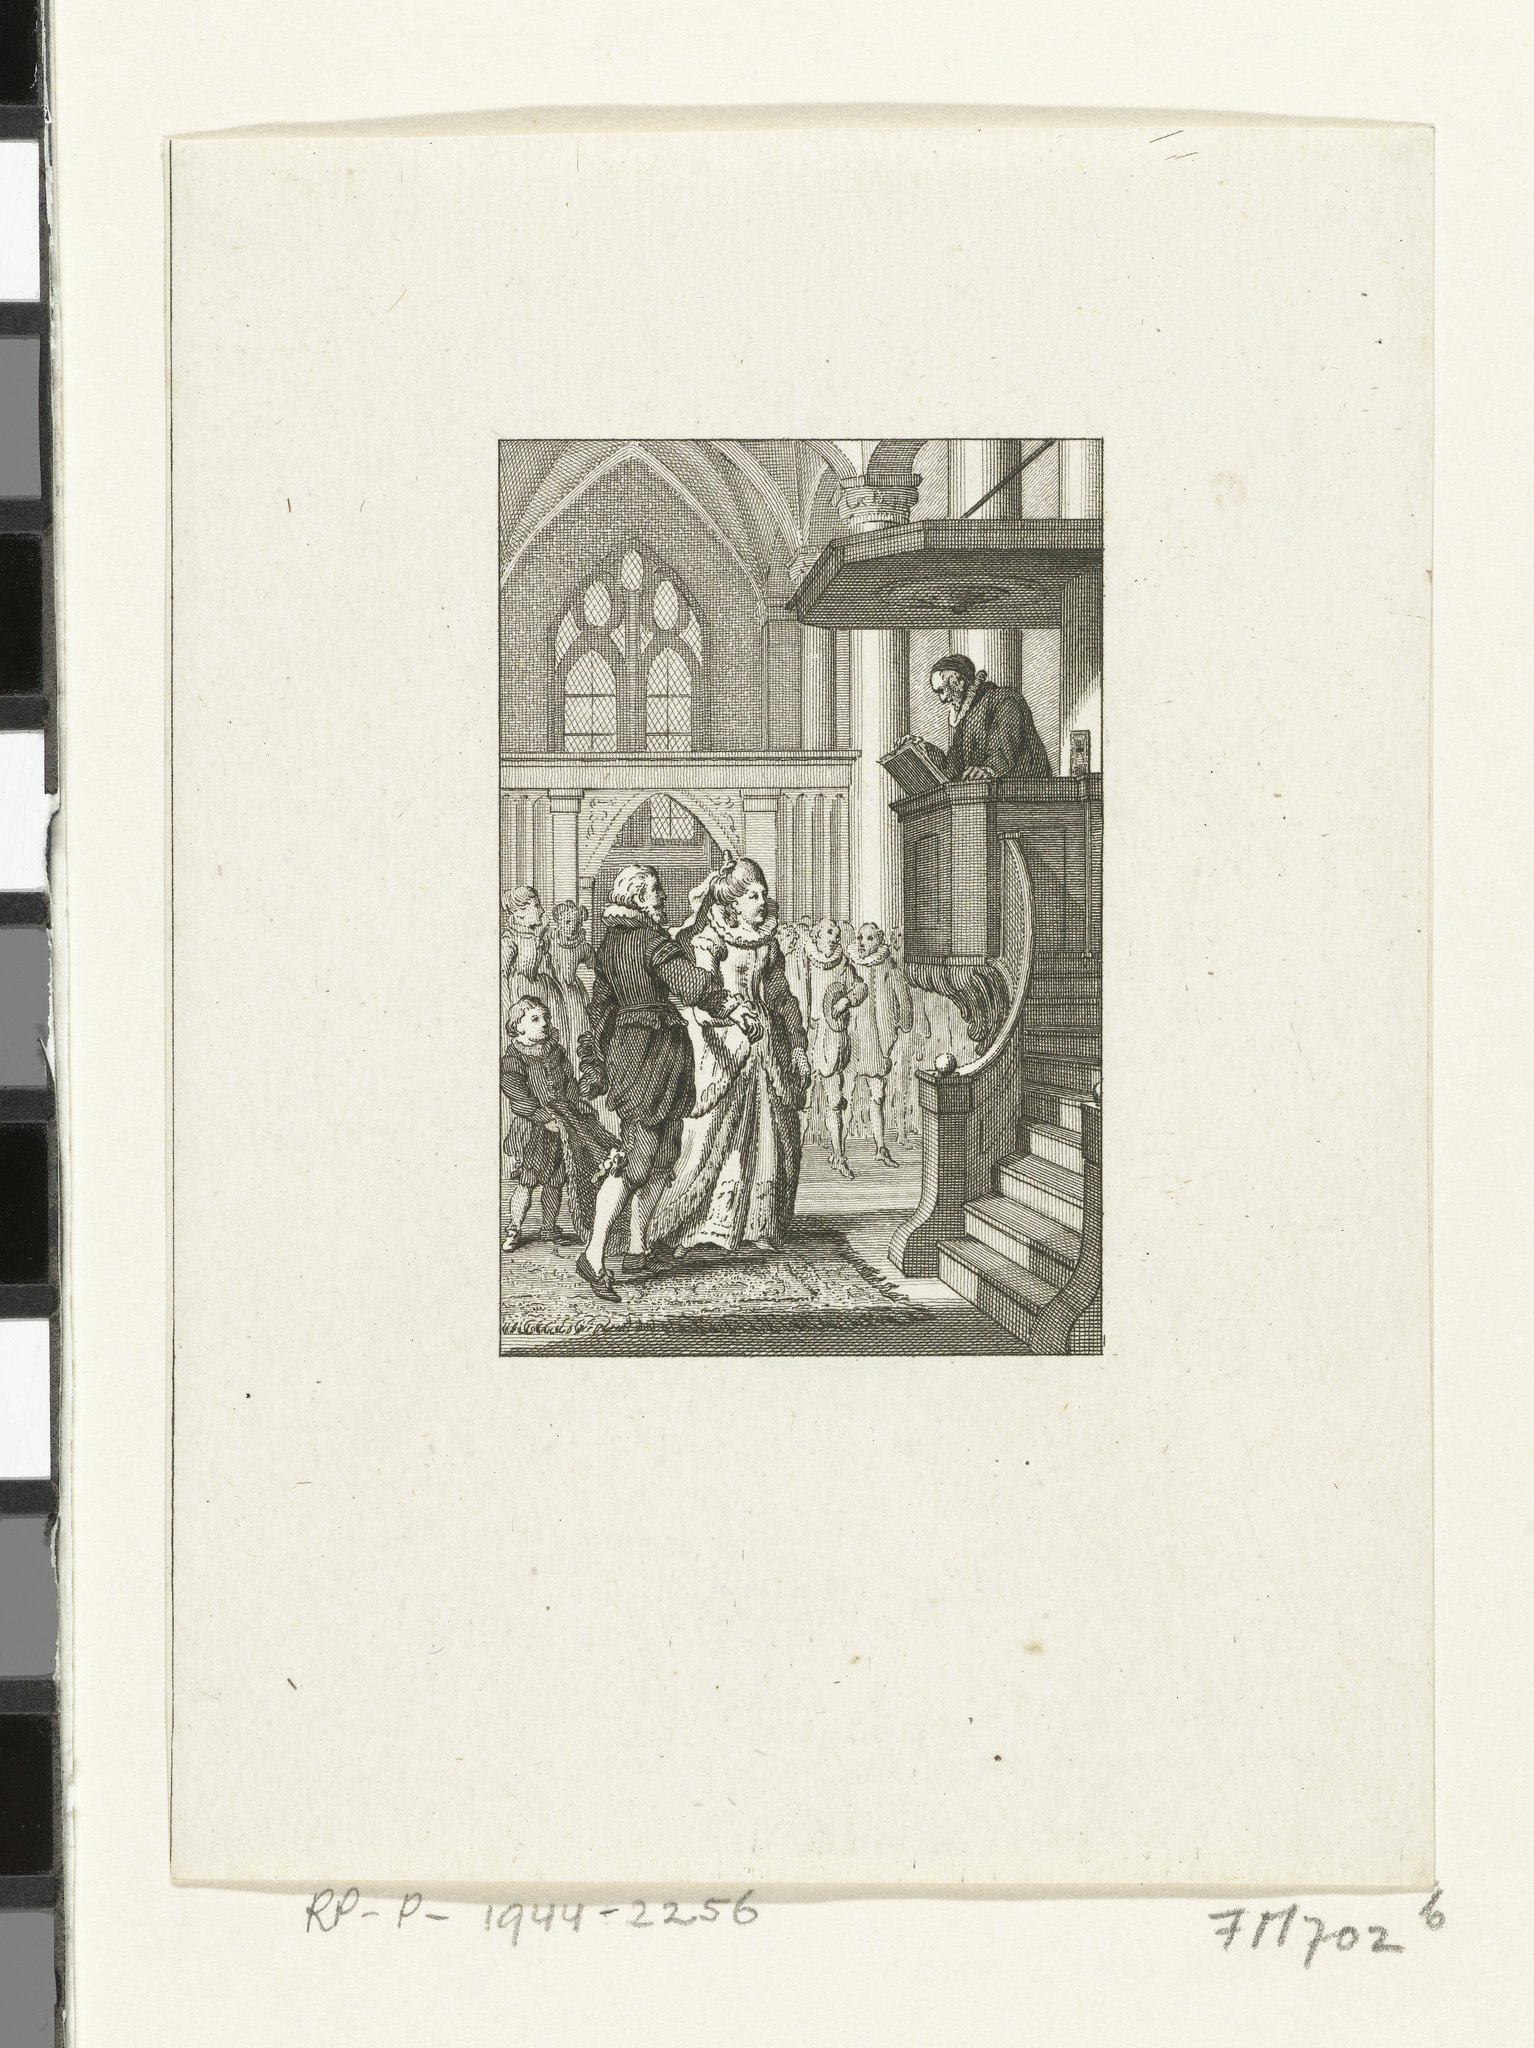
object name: history print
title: Huwelijk van Willem van Oranje en Charlotte de Bourbon, 1575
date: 1780-1795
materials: paper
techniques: etching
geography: netherlands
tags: antwerp, charlotte of bourbon, william i (prince of orange), (civil) marriage ceremonies, marriage ~ protestant service, brielle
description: Gebruikt als illustratie in: J. Fokke, Geschiedenissen der Vereenigde Nederlanden voor de vaderlandsche jeugd, Johannes Allart, Amsterdam 1783-1795, 25 delen, dl. V, pl. II.